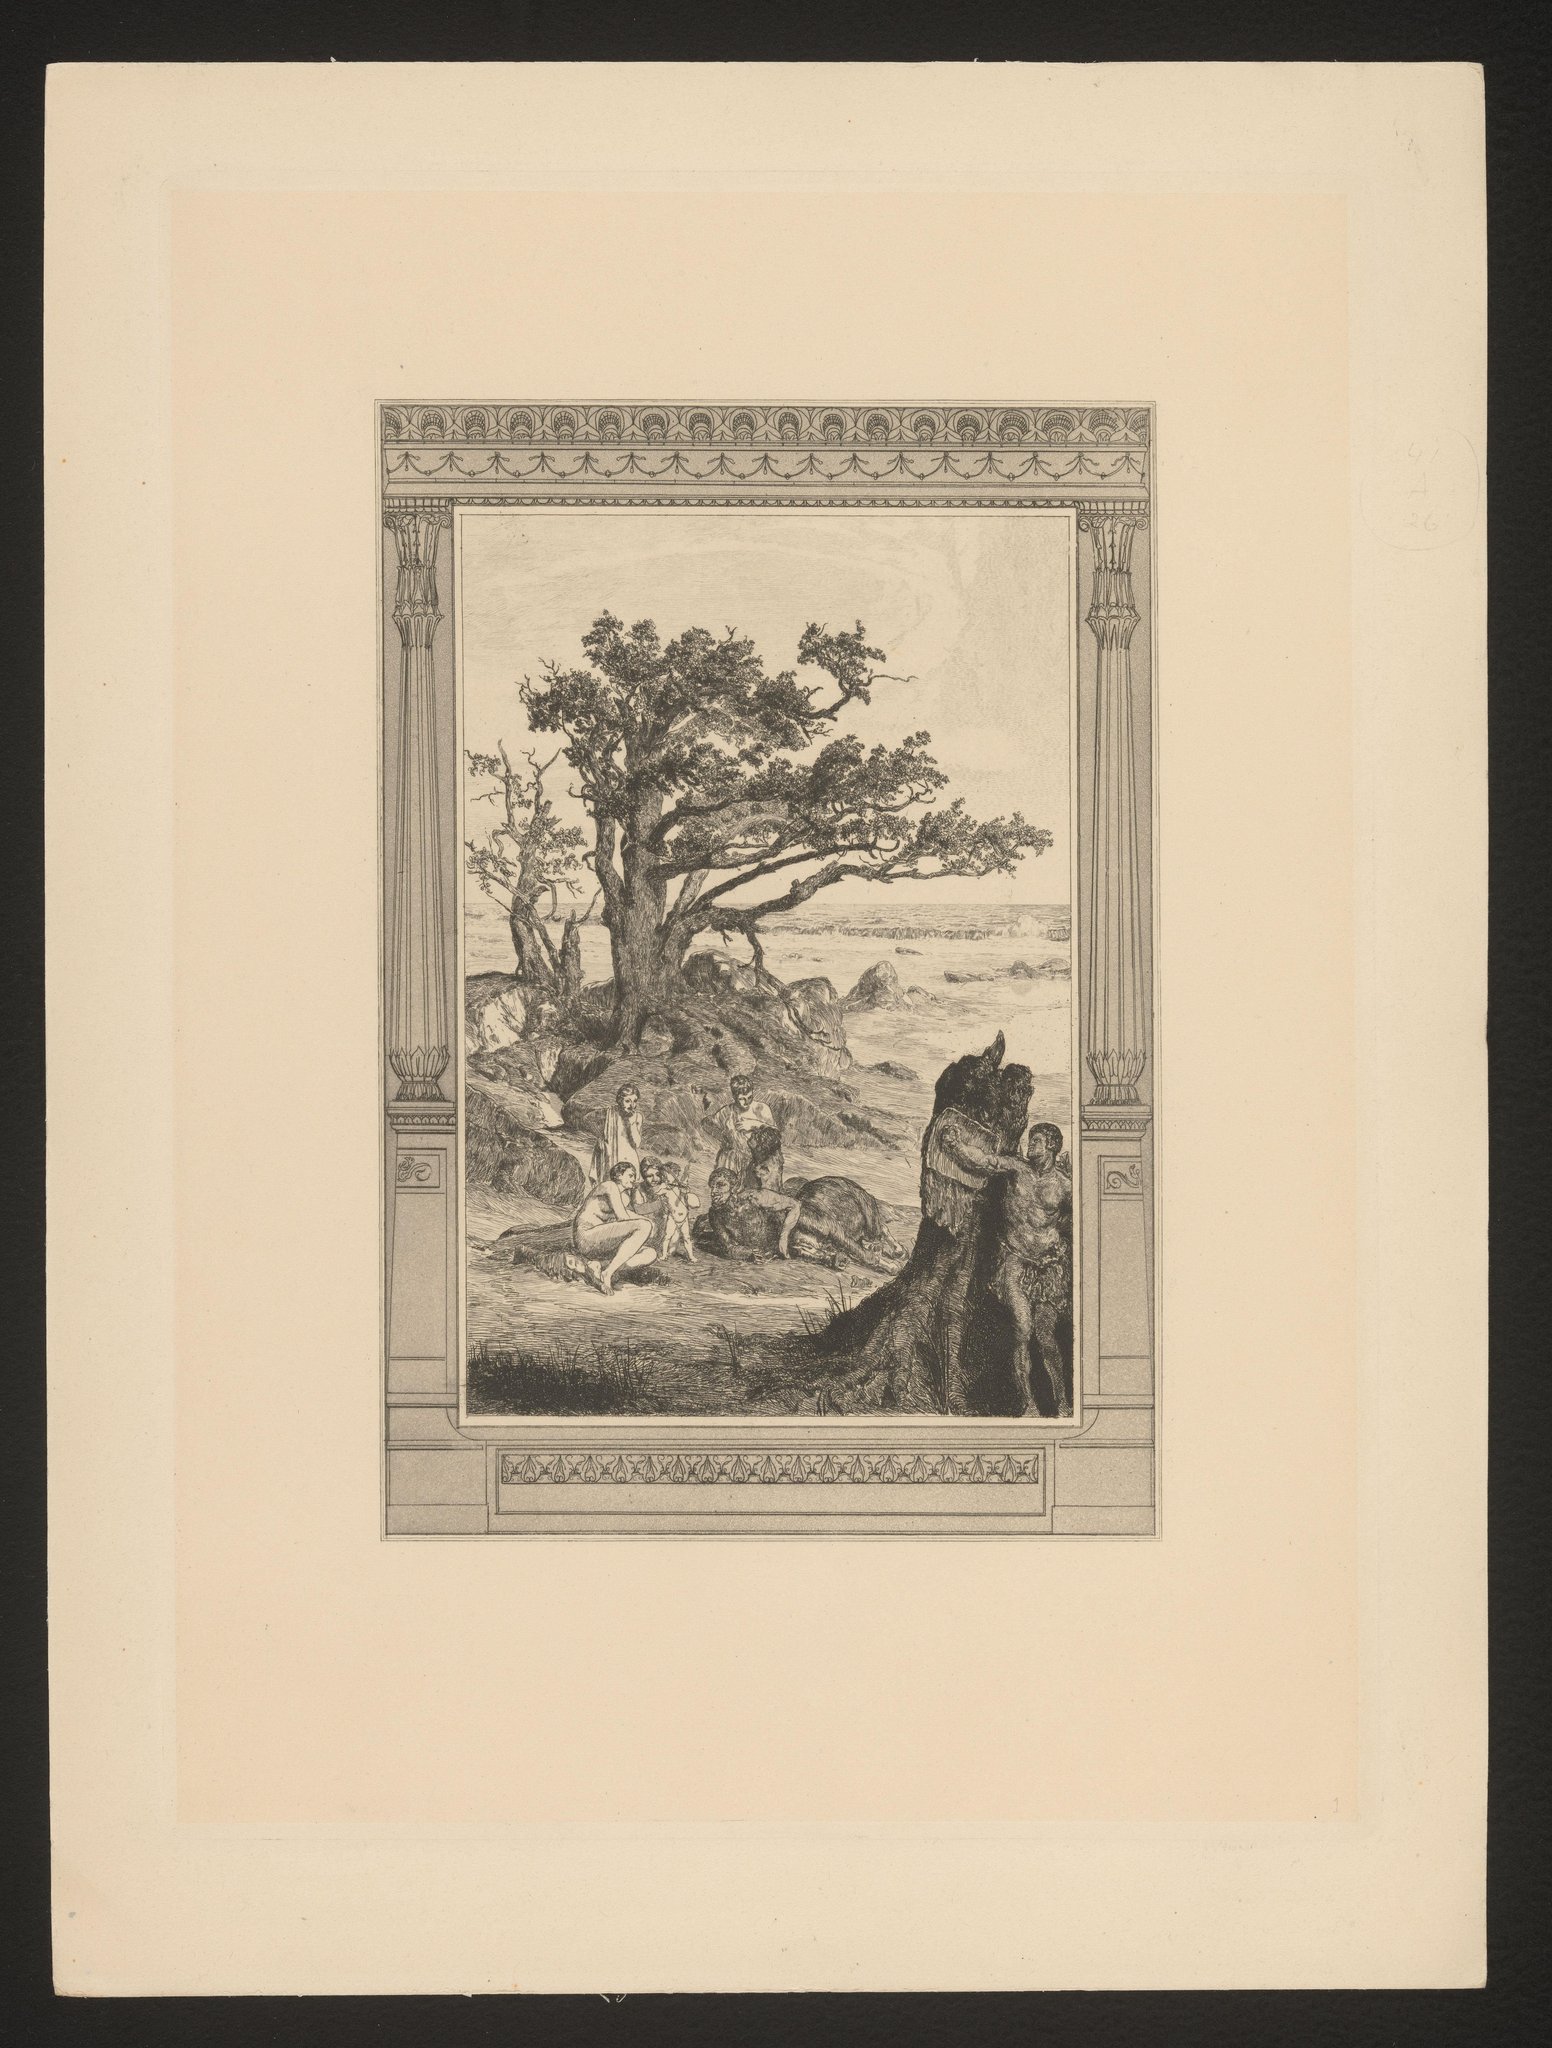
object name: print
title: Radierungen zu Apulejus' Märchen Amor und Psyche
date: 1880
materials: paper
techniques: aquatint, etching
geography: nuremberg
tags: infancy, upbringing of cupid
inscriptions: collector's mark: Lugt 2228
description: Bij vier nimfen en een sater leert Amor boogschieten. In decoratief kader.